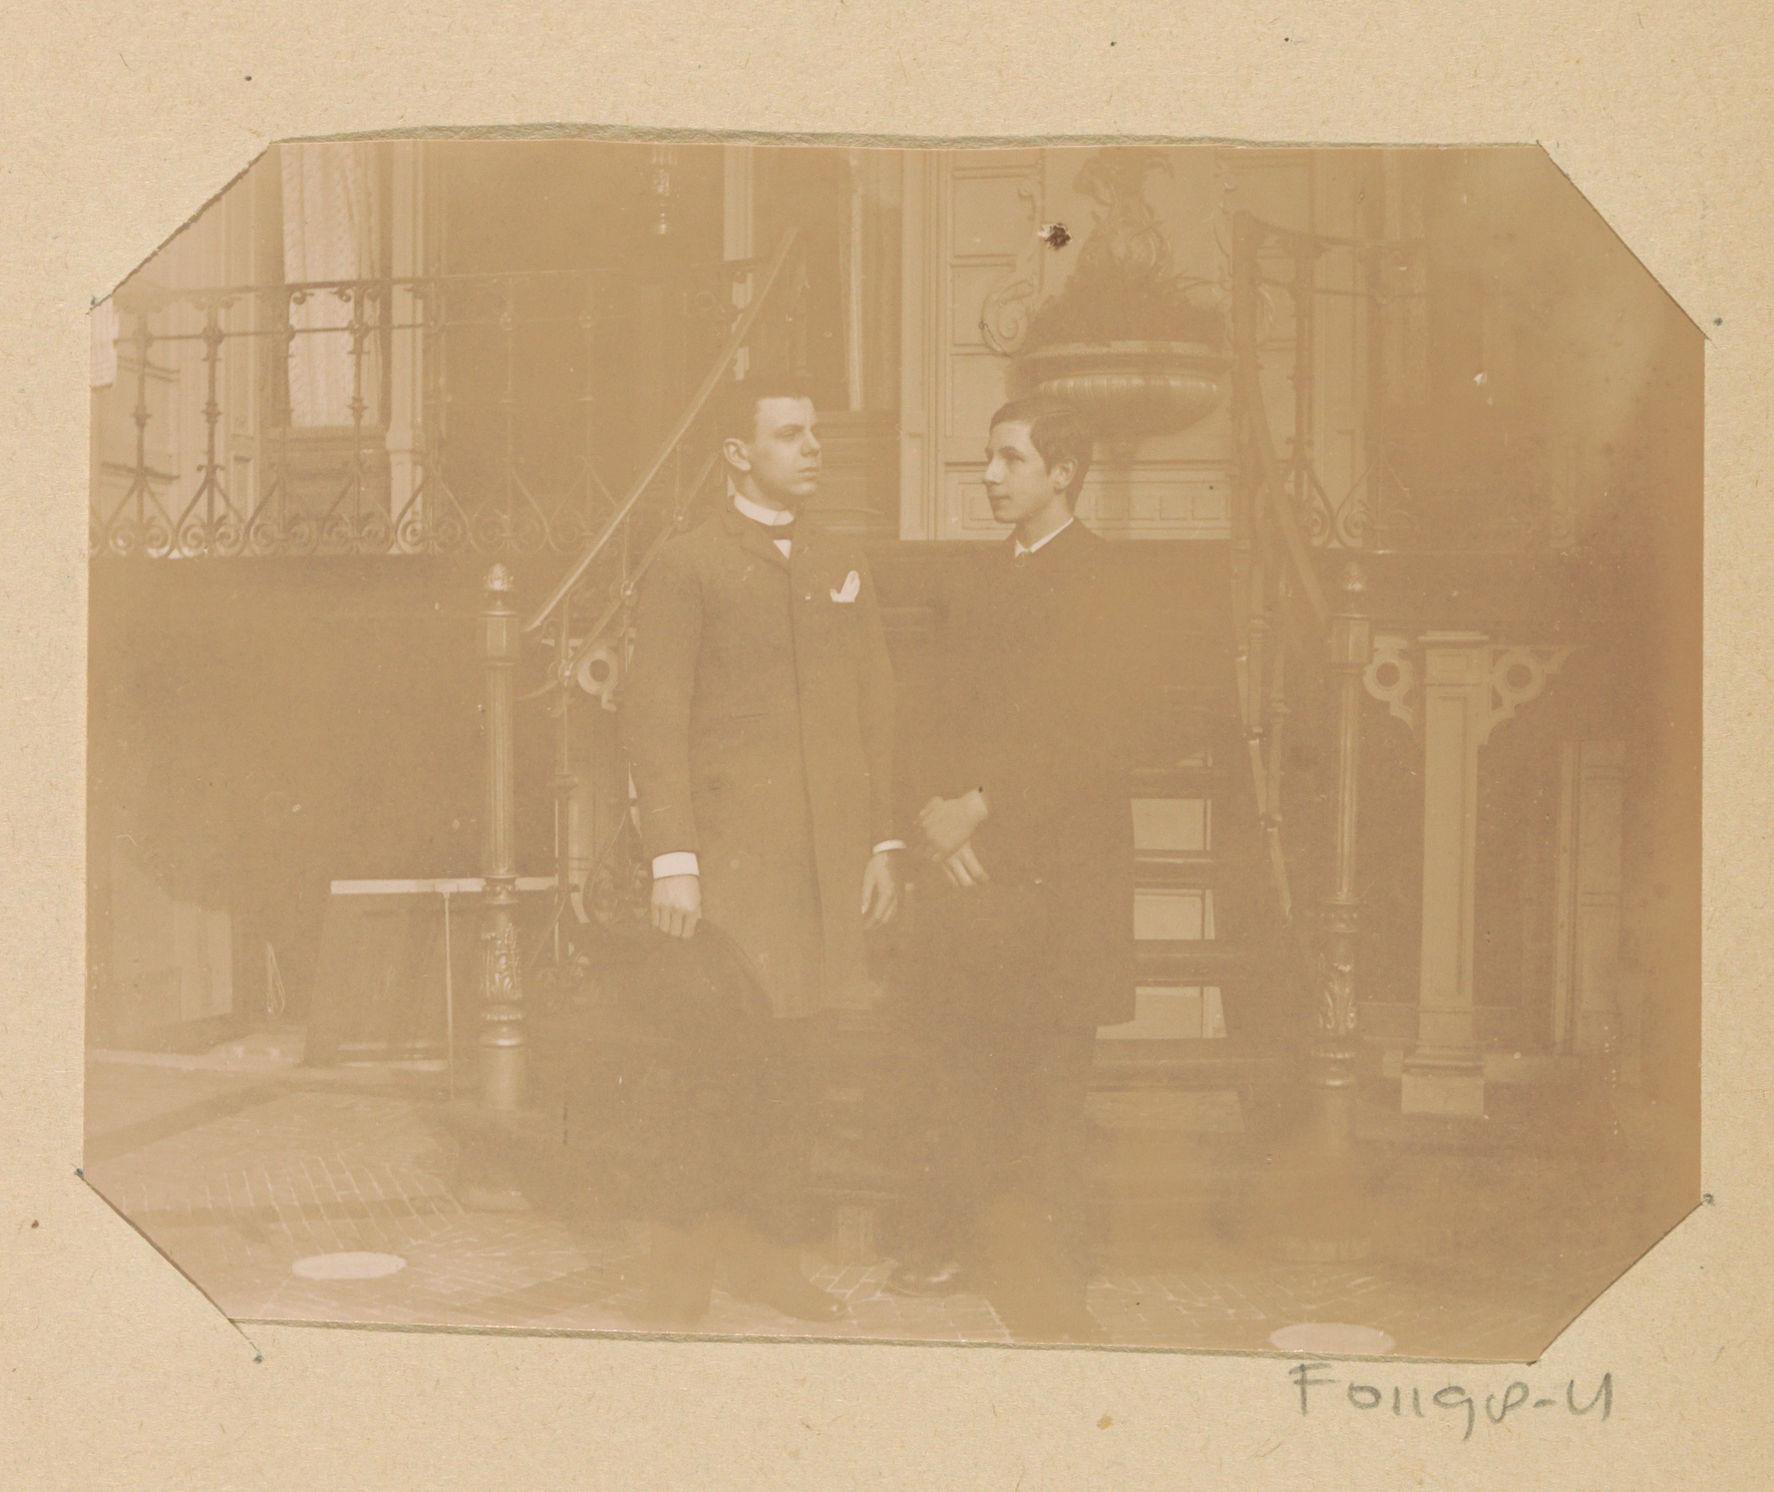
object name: album leaf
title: Twee onbekende jonge mannen op een buitentrap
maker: johanna margaretha piek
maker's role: fotograaf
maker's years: 1870-1947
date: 1889-1893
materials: paper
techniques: gelatin silver print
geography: netherlands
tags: youth, adolescent, netherlands